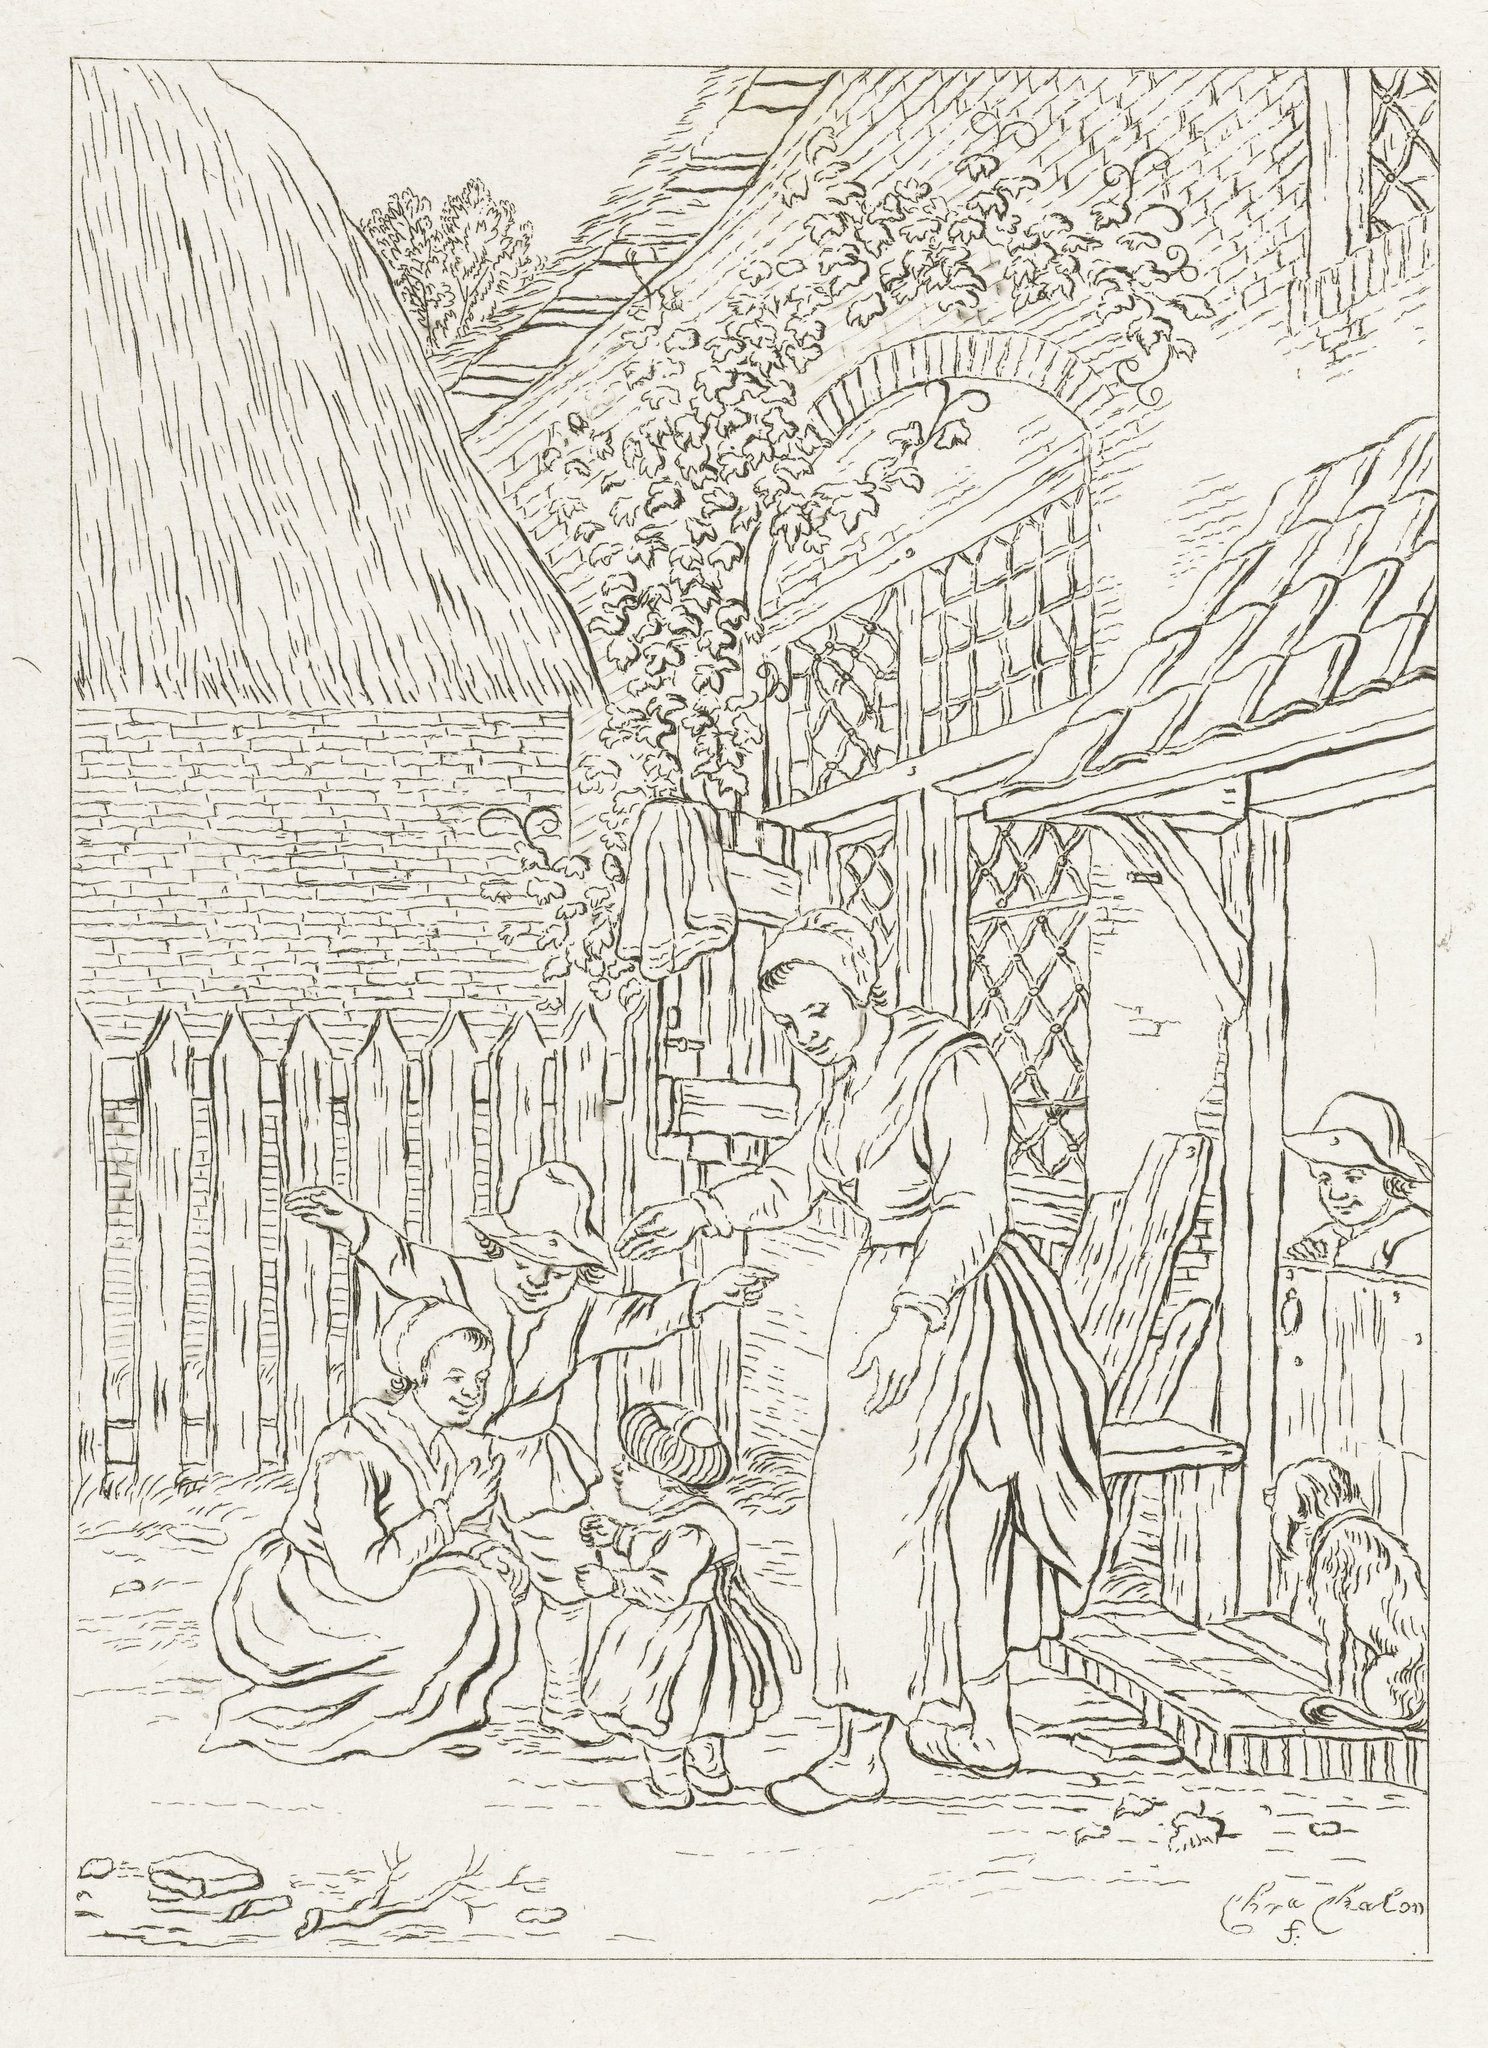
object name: print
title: Eerste stapjes van een kind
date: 1779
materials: paper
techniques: etching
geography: leiden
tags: farmers, farmers - aa - female farmer, farmer's wife, mother and baby or young child, mother and son(s) (family group) (with number of sons), head-protector (~ learning to walk), learning to walk, the first steps, farm (building)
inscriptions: collector's mark: Lugt 2233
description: Het erf van een boerderij. Een peuter leert zijn eerste stapjes zetten, onder het toeziend oog van zijn moeder, alsook de keukenmeid, een hond en twee broertjes.